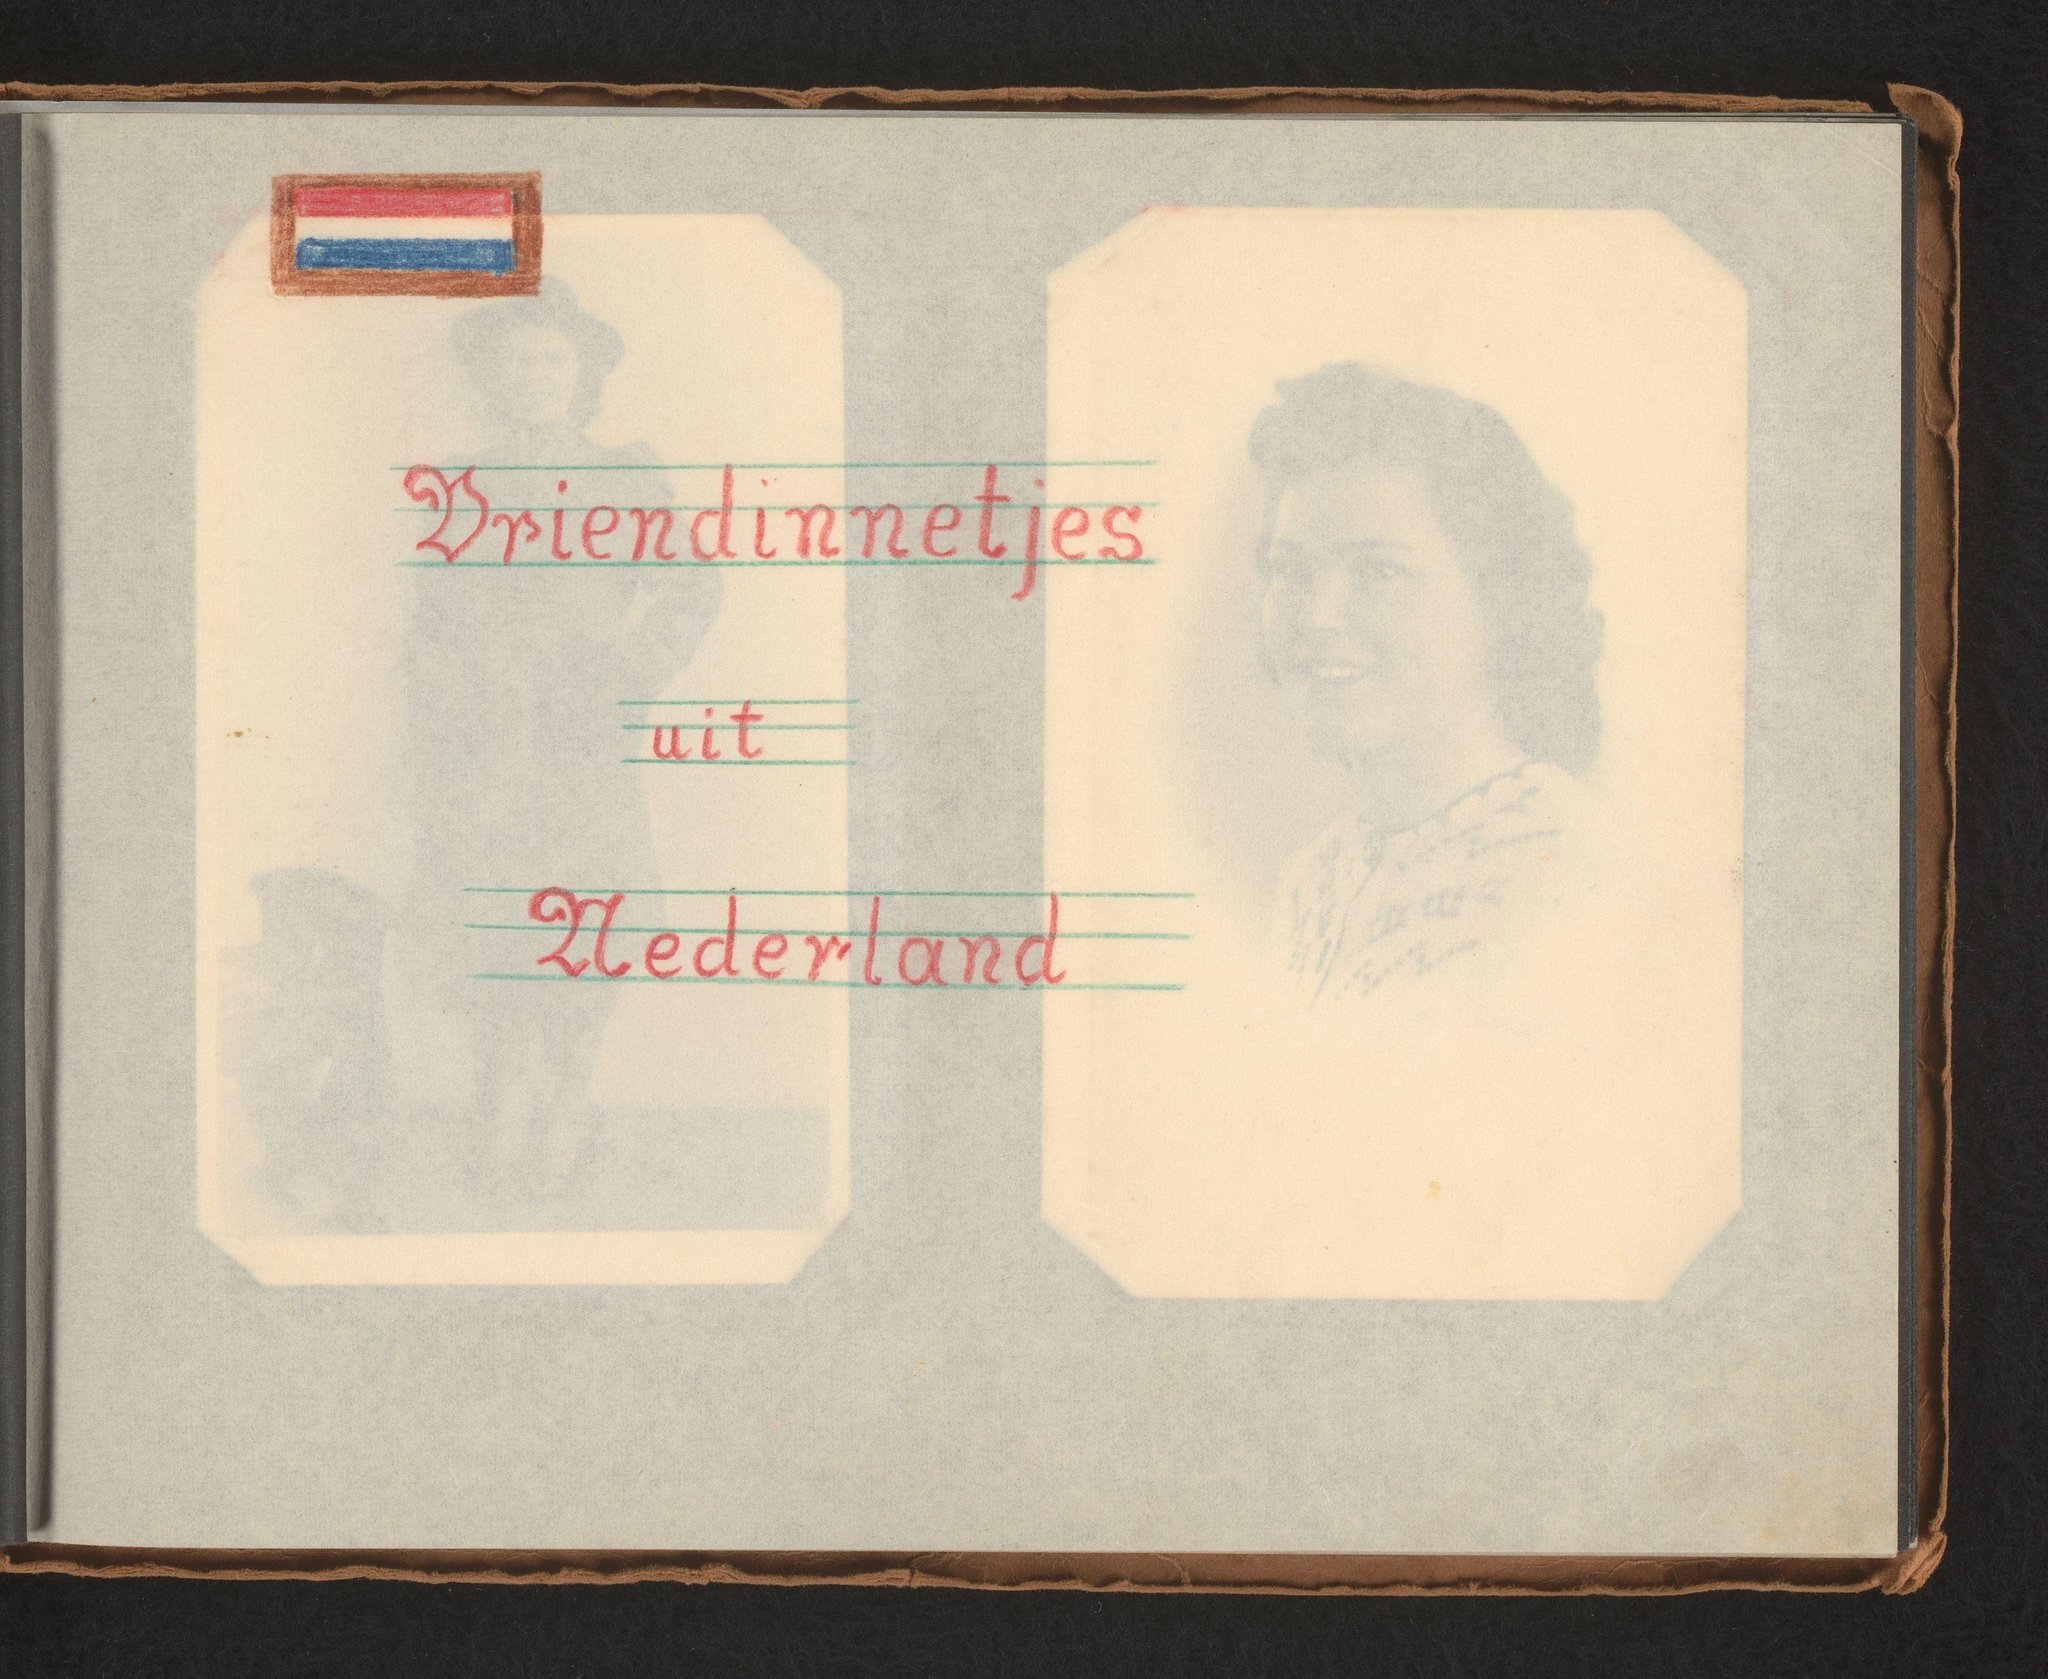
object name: album leaf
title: Vriendinnetjes uit Nederland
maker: werner neufang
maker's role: militair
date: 1940-1945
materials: paper, pencil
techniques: writing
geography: germany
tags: kriegsmarine, tweede wereldoorlog, bezetting van nederland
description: Blad met tekst en getekende Nederlandse vlag. Tussenblad tussen bladzijde 4 en 5. Onderdeel van een fotoalbum over de Duitse Werner Neufang van de Kriegsmarine en de Nederlandse Thea Driesen.